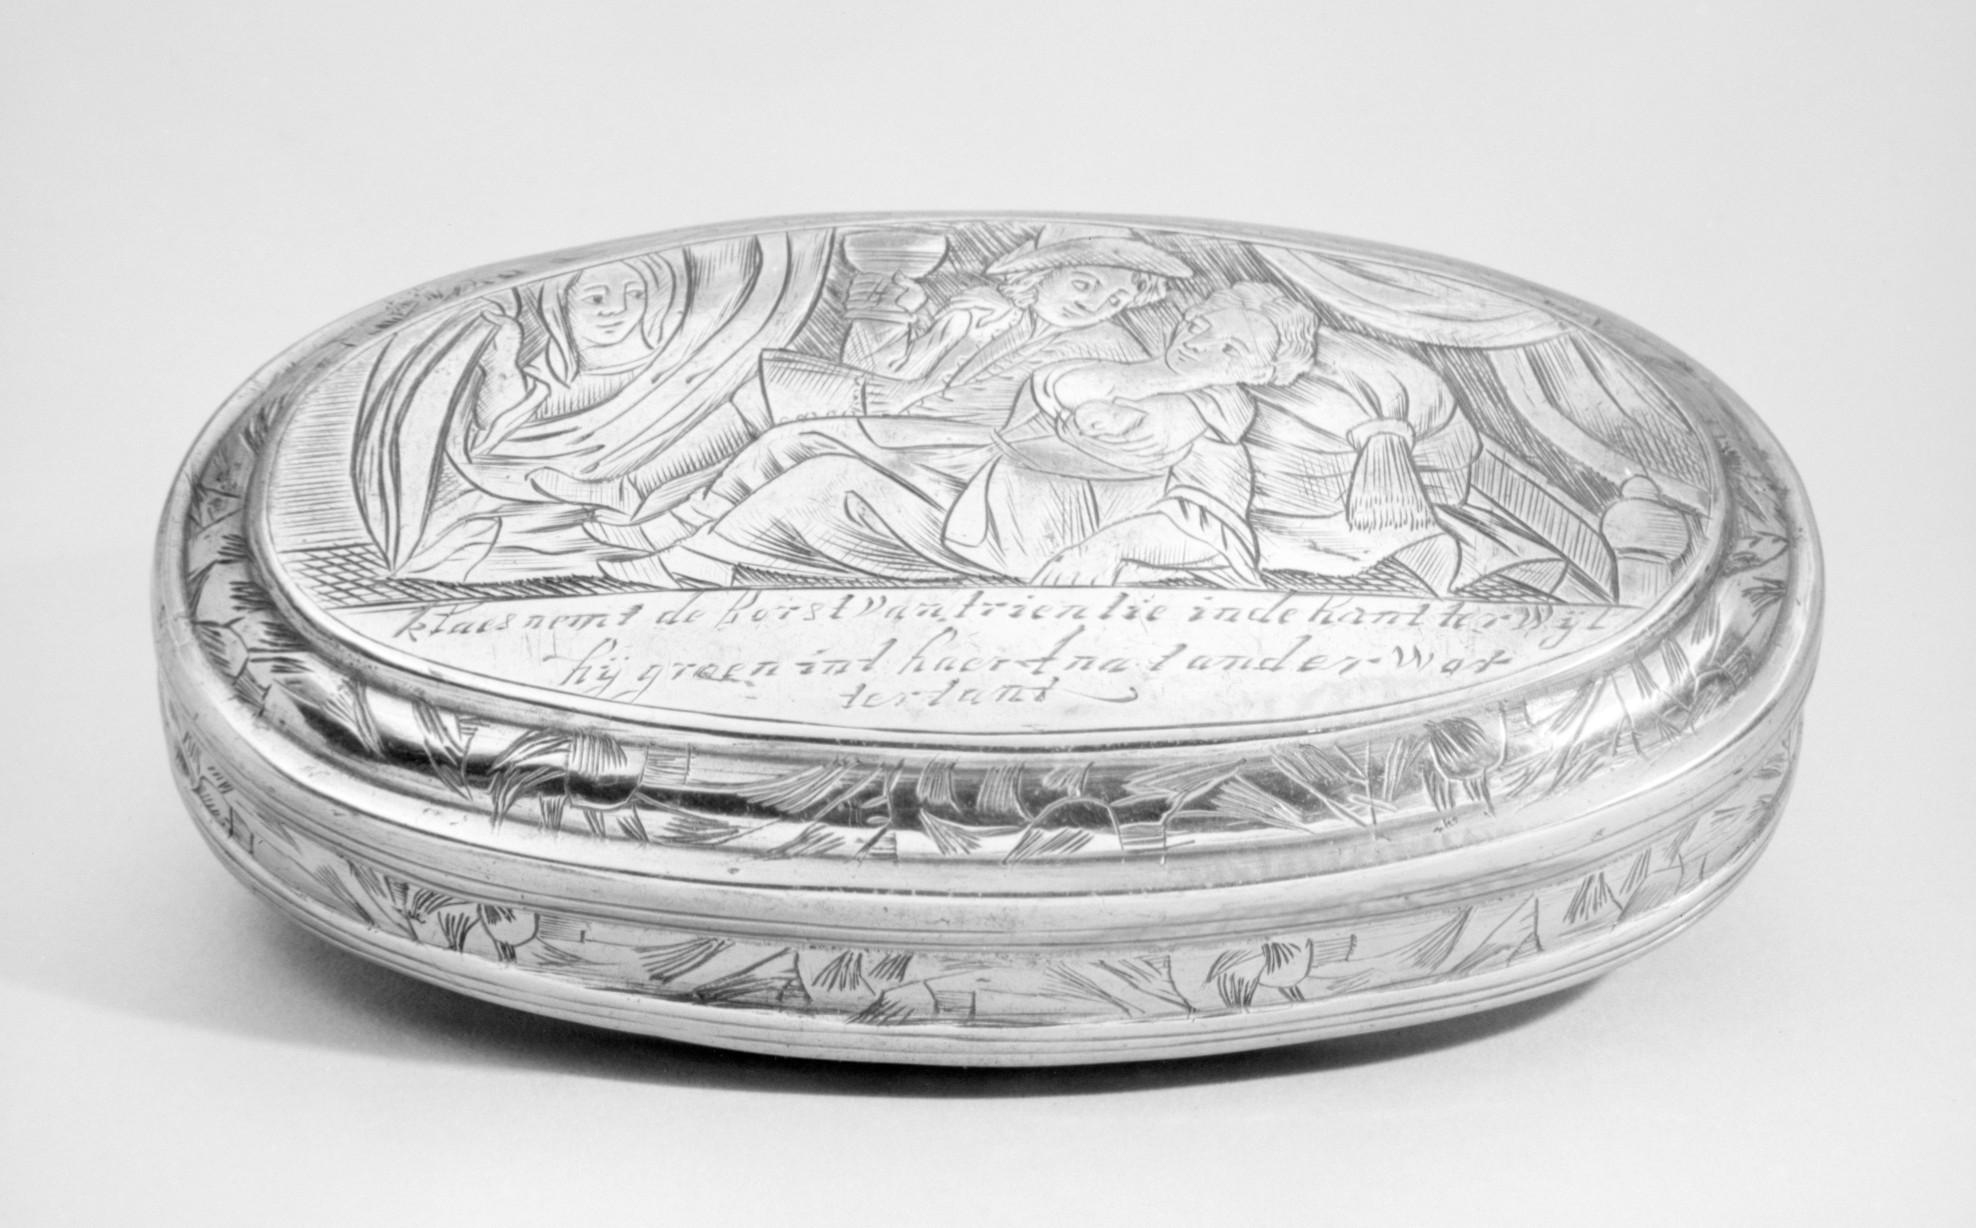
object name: tobacco box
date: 1701-1800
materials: brass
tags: men,women